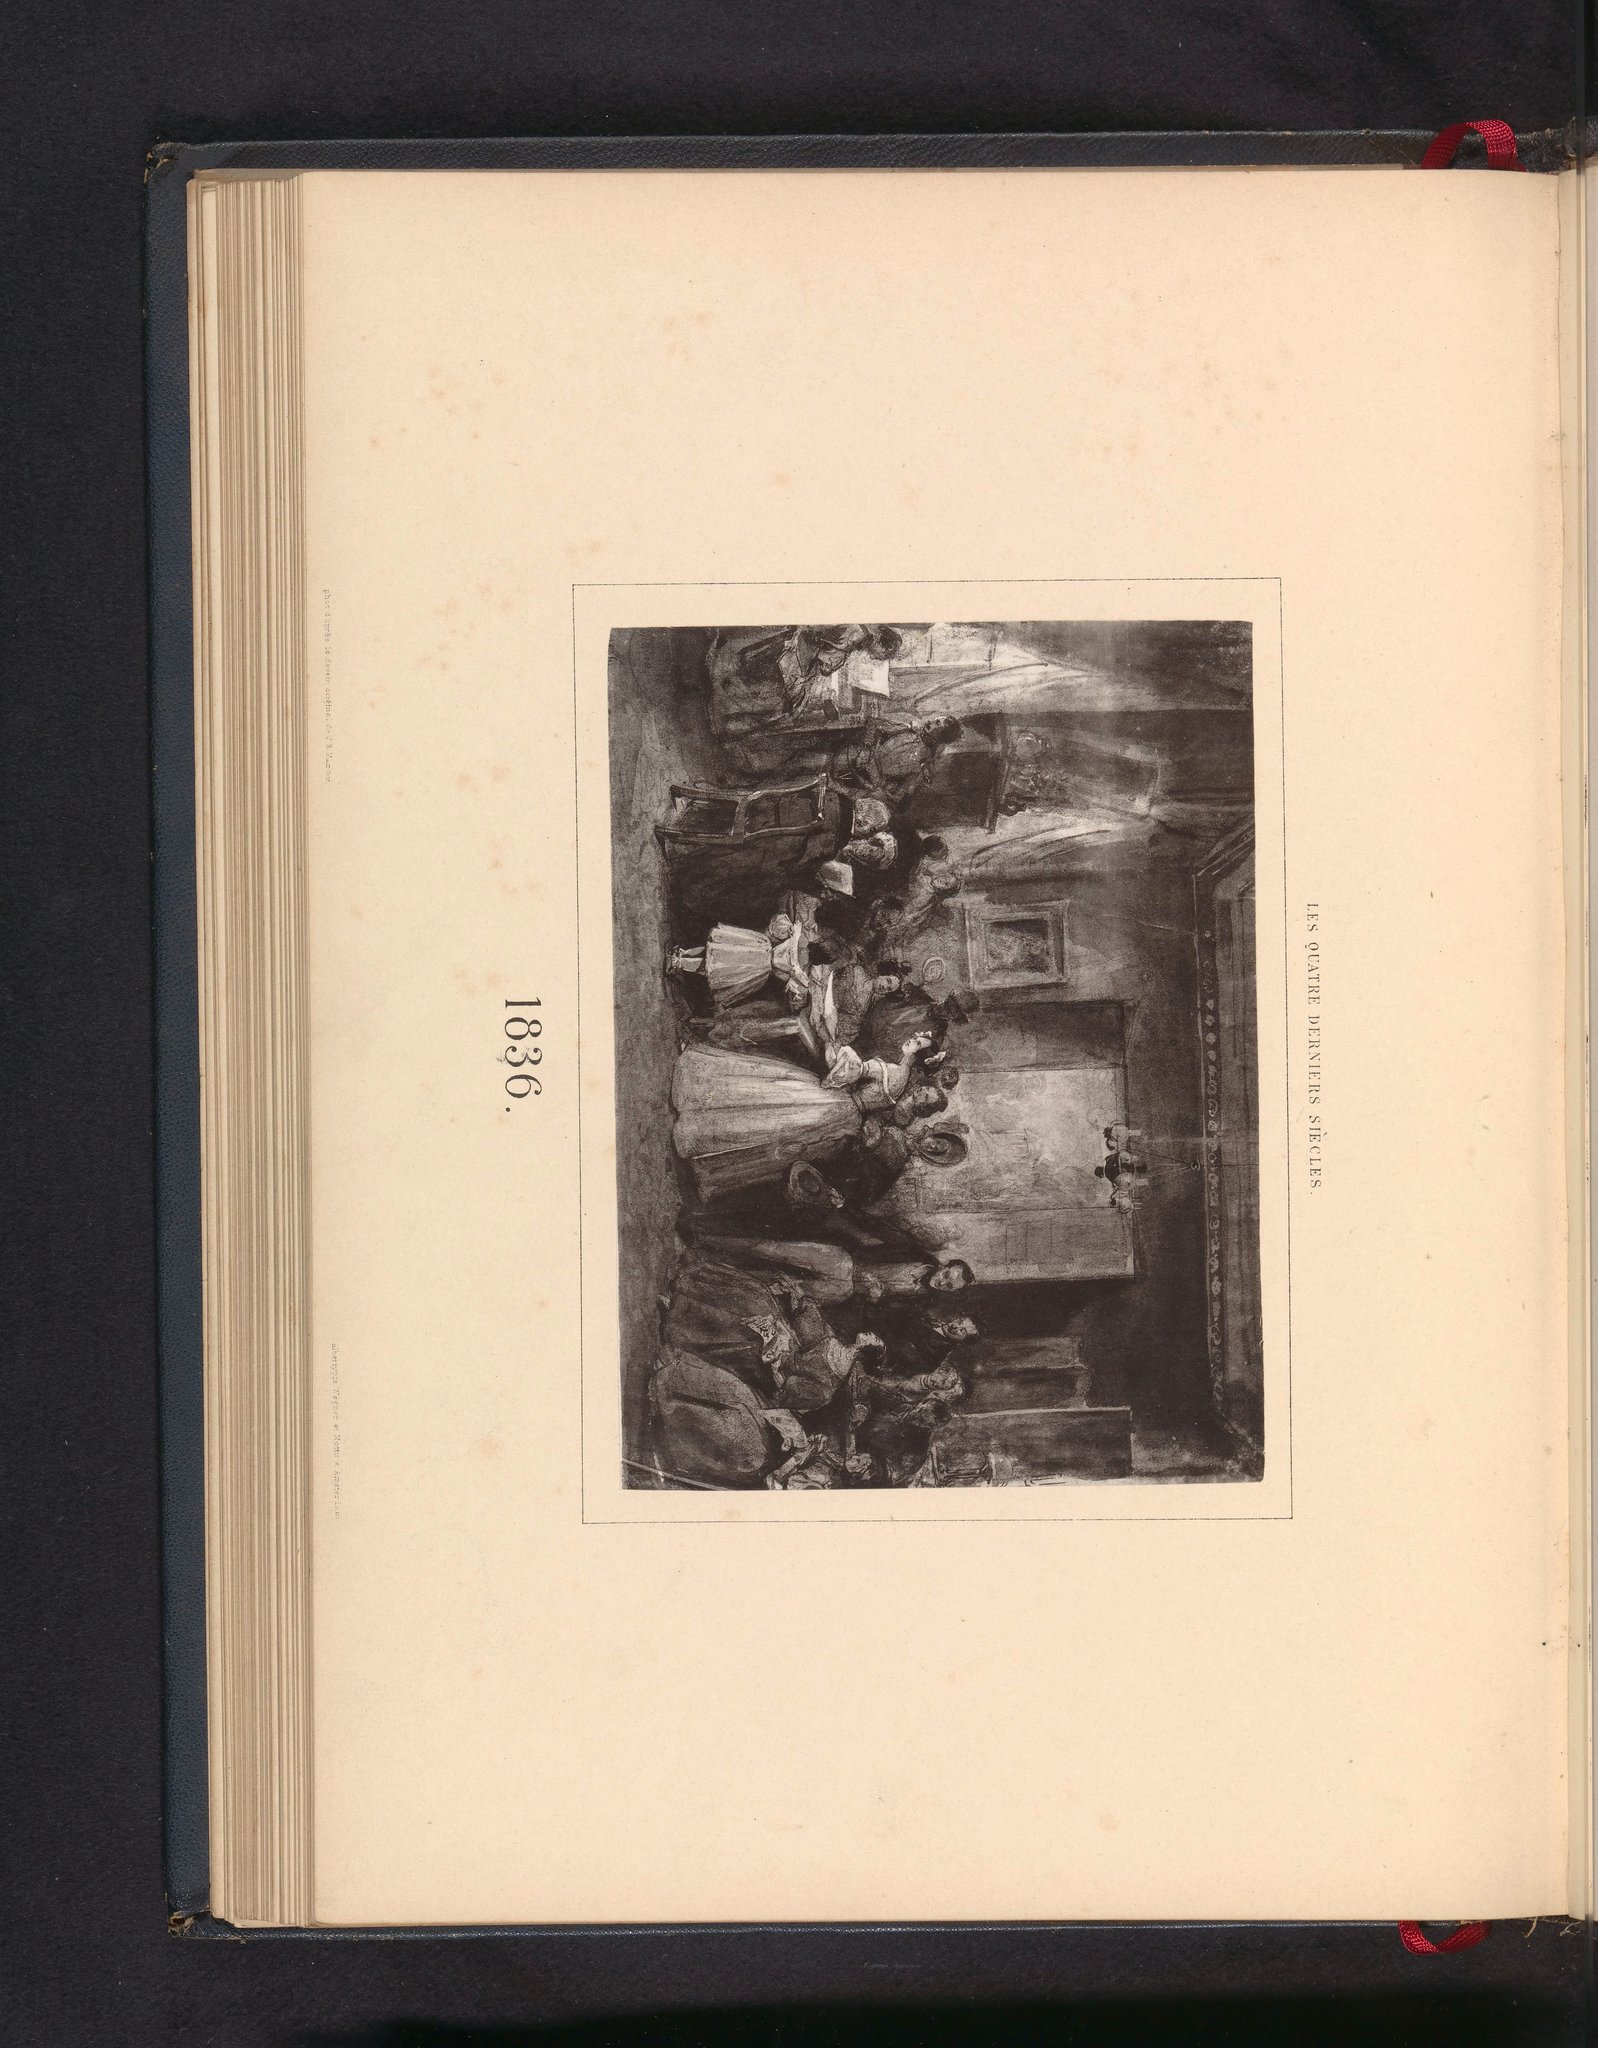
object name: reproduction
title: 1836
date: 1868-1873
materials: paper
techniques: photograph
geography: amsterdam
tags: interior ~ representation of a building, nobility and patriciate; chivalry, knighthood